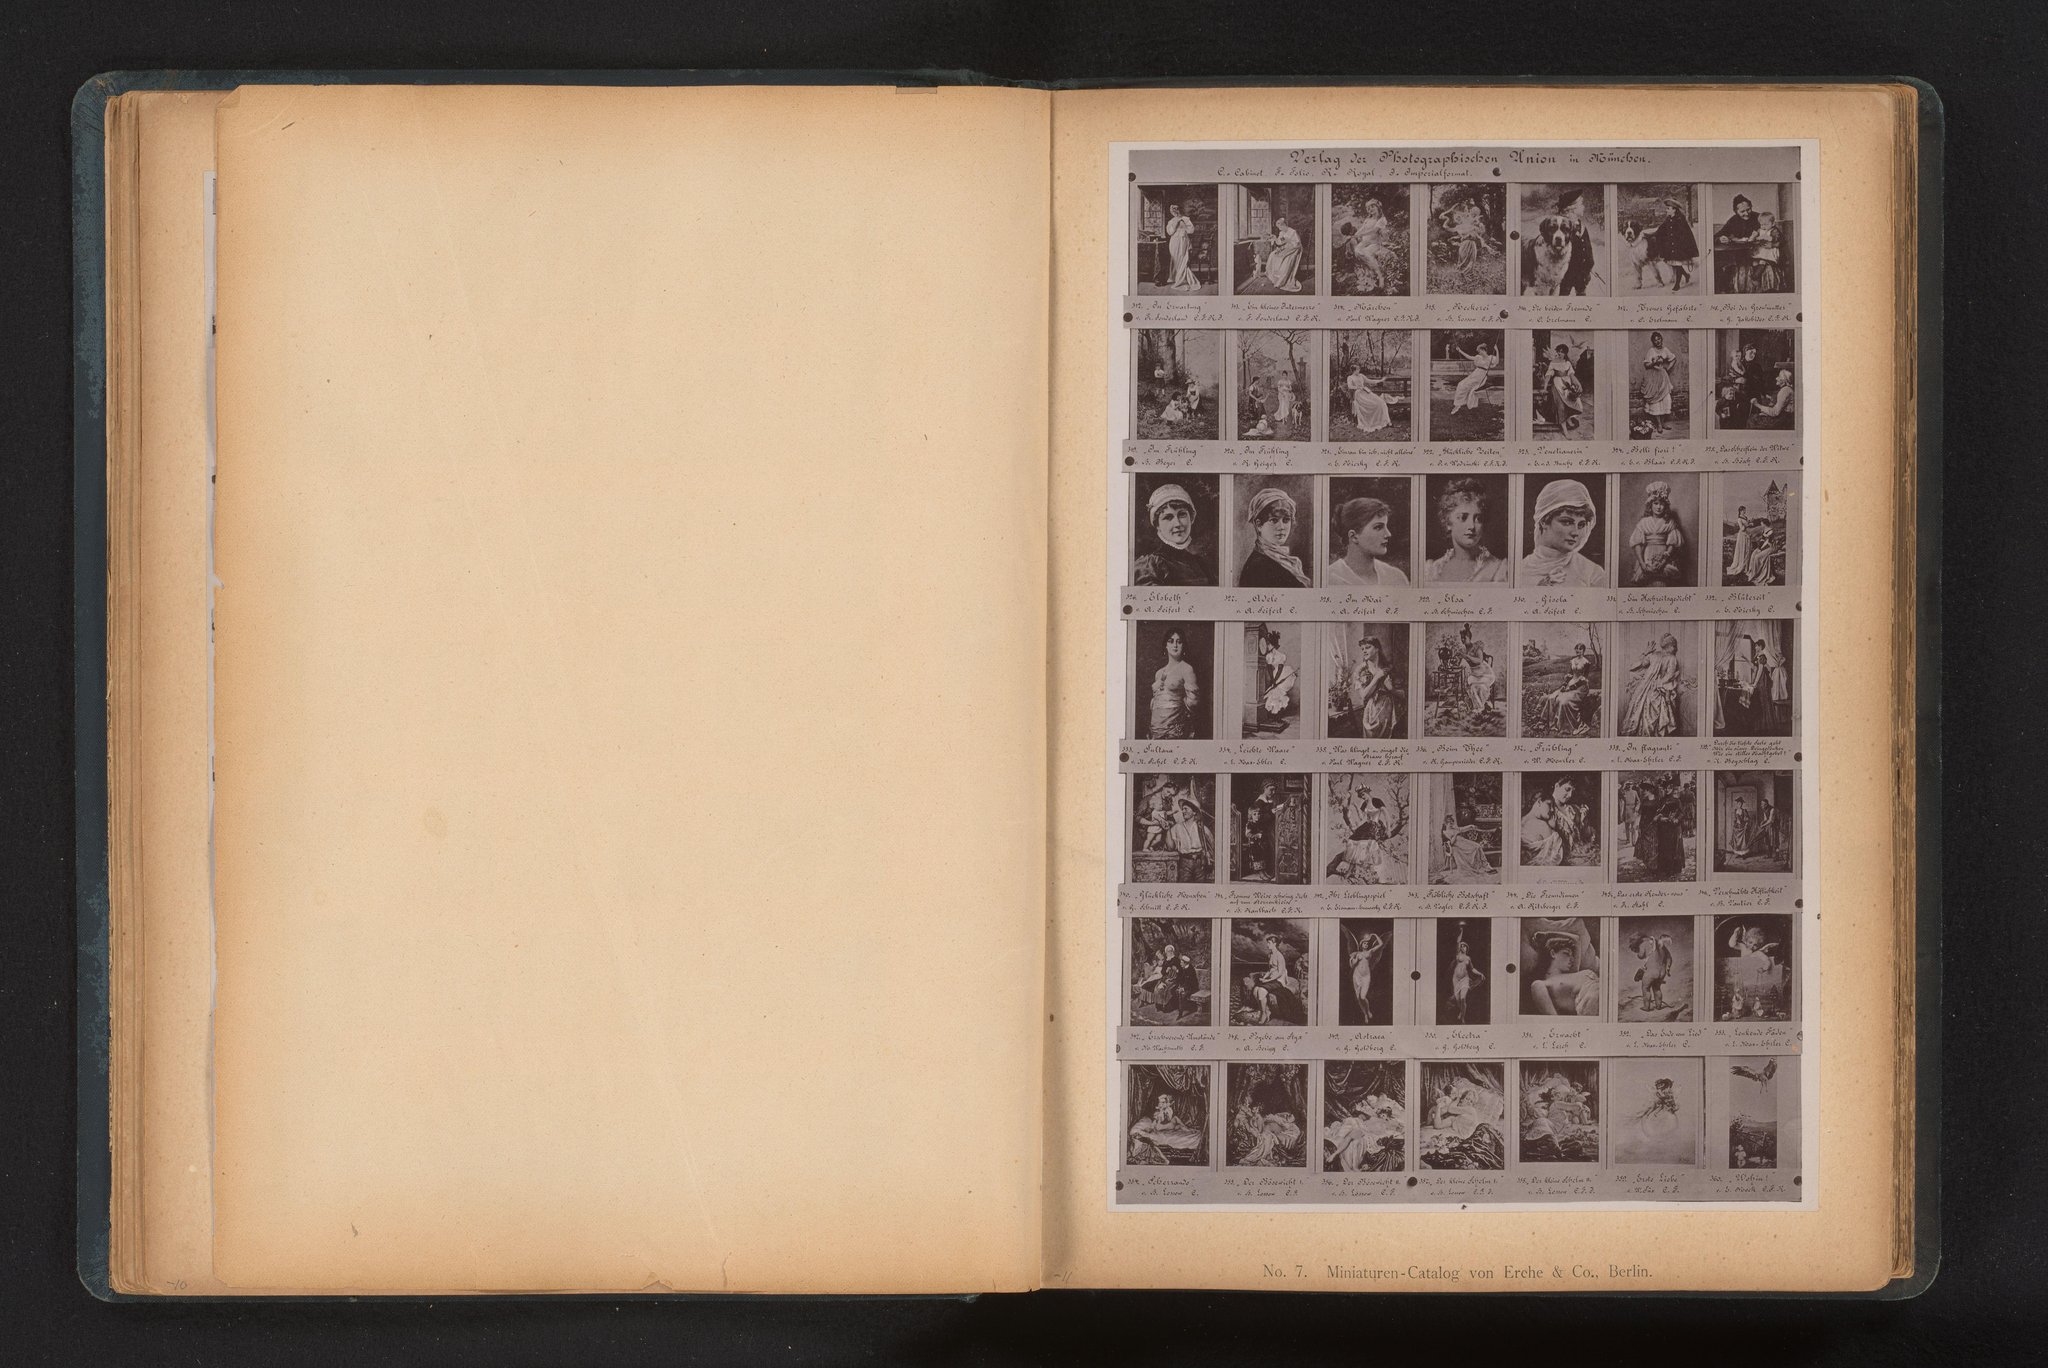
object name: page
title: Fotoreproducties van 49 geschilderde portretten van onbekende vrouwen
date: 1880-1885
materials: paper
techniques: photograph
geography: berlin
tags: historical persons not known by name - bb - woman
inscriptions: number: ‘No. 7.’